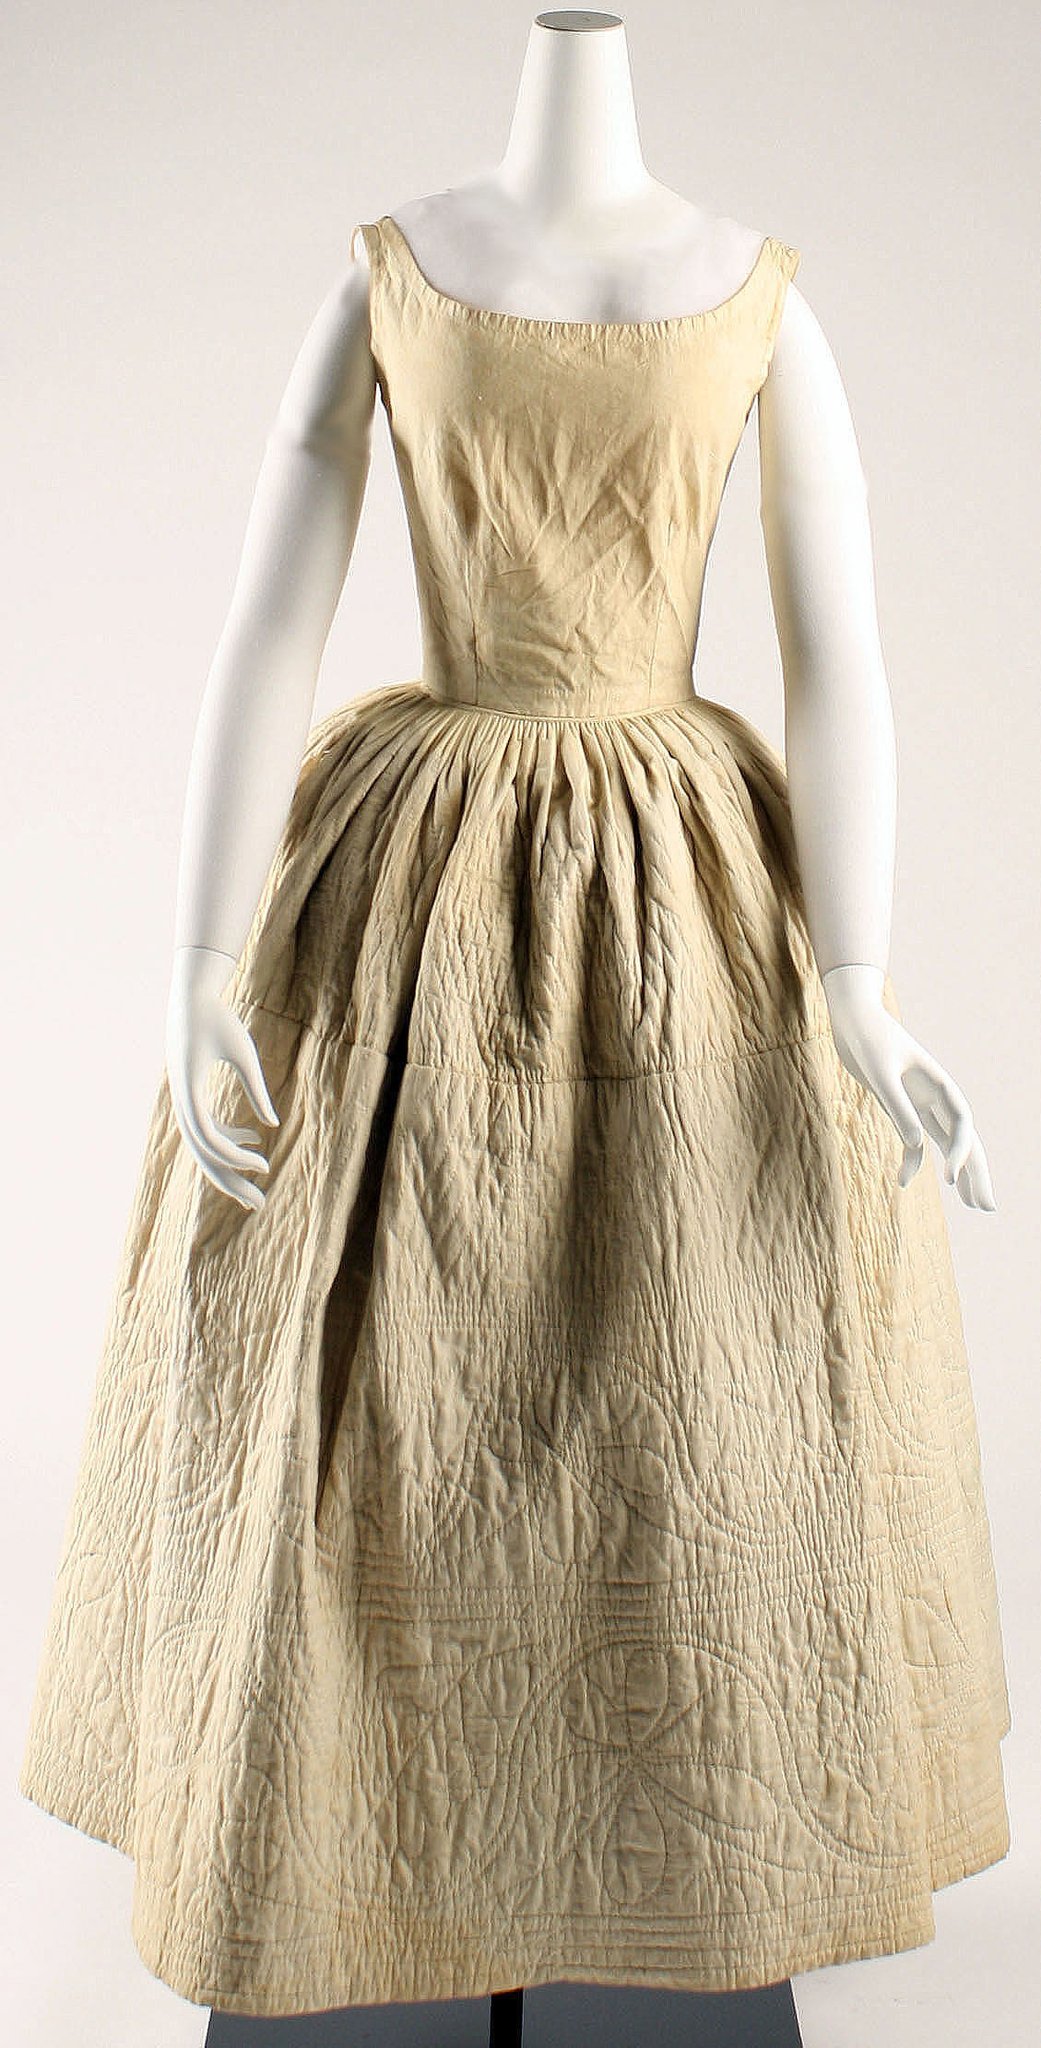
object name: petticoat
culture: american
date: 1834-1866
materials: cotton